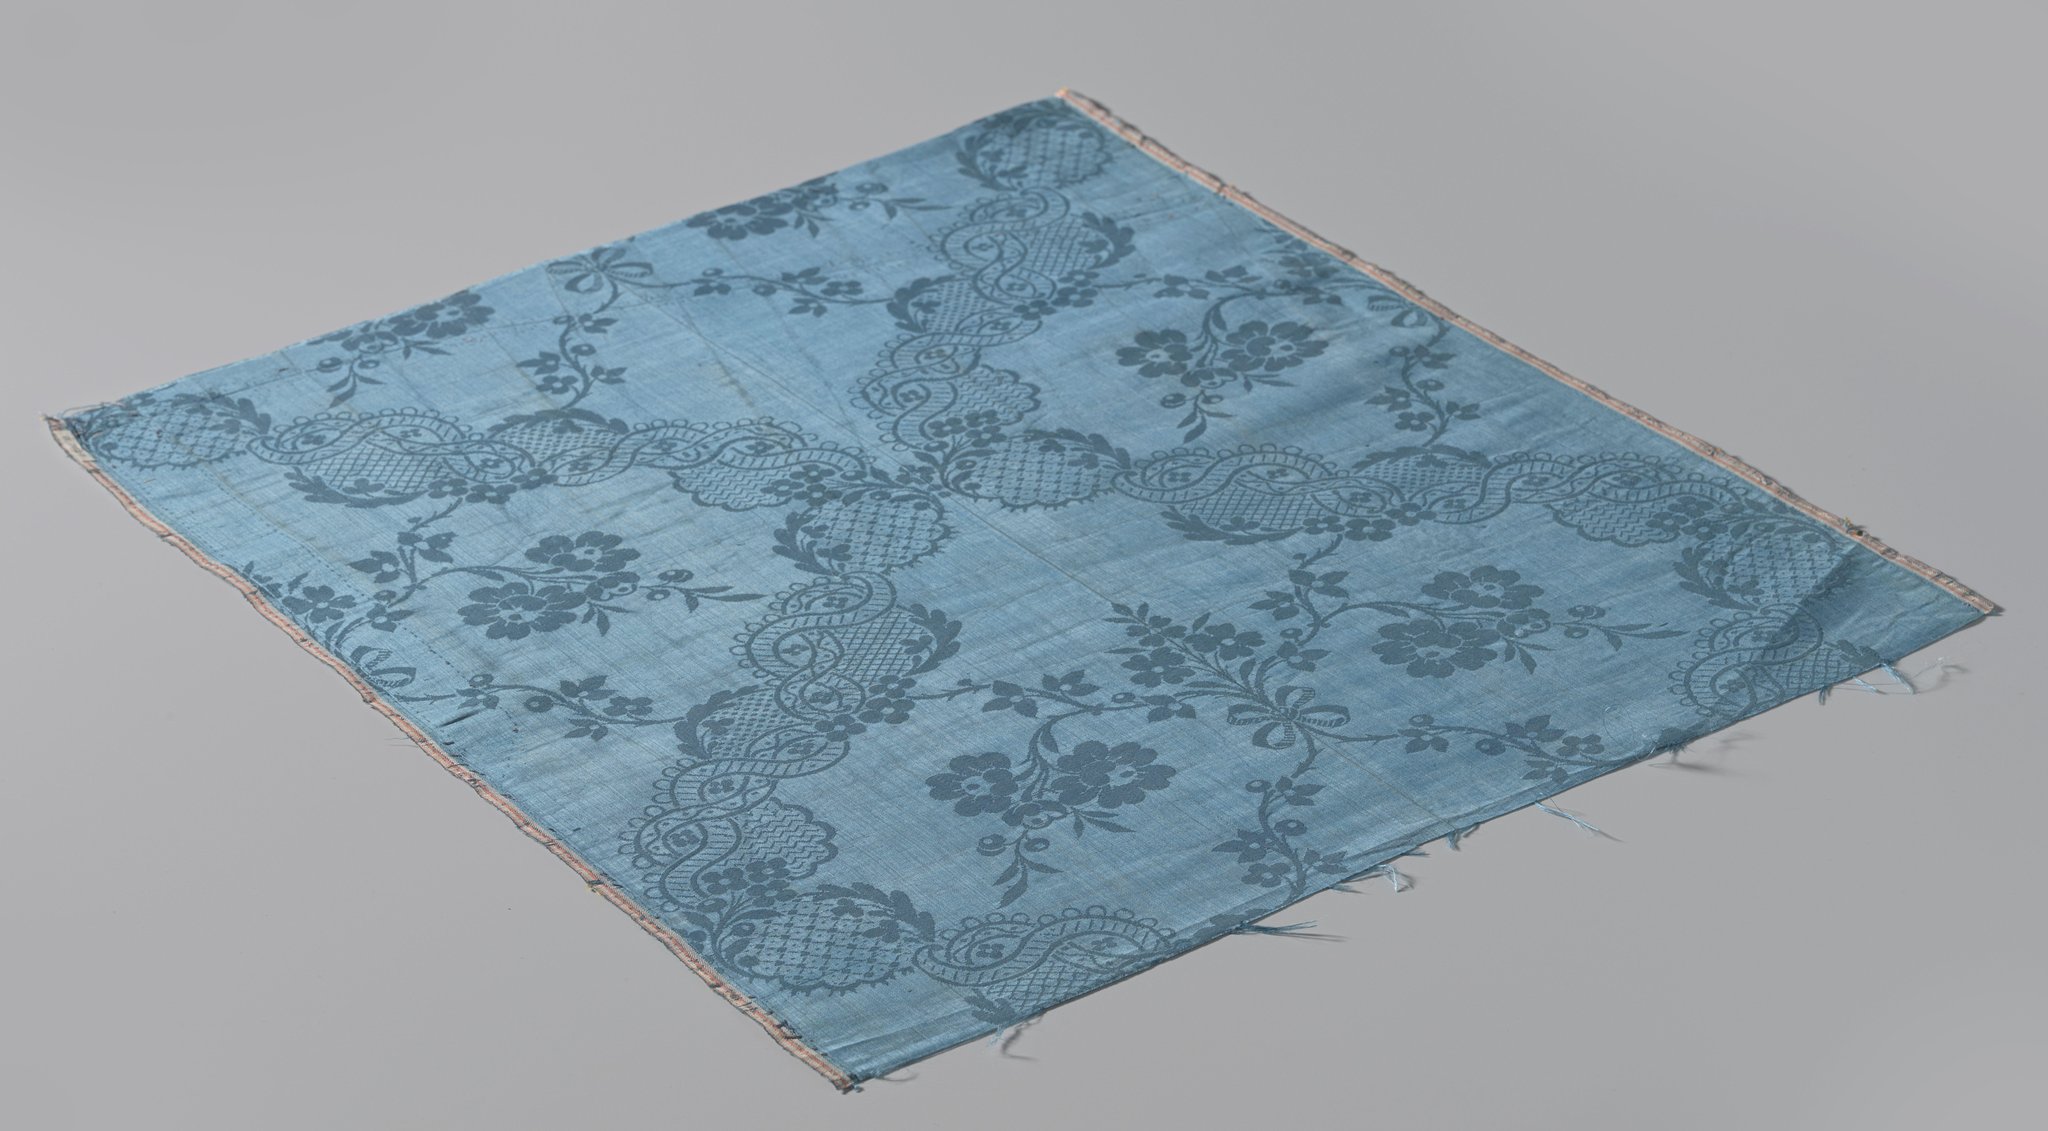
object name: zijdedamast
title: Fragmenten zijdedamast, blauw, met patroon van bloemen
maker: Anonymous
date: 1760-1770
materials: silk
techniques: damask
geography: france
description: Fragmenten zijdedamast, blauw, met patroon van bloemen. In een brief uit 1976 van de heer C. Burgers, gevonden in de losse doucmentatie wordt over vier fragmenten gesproken.